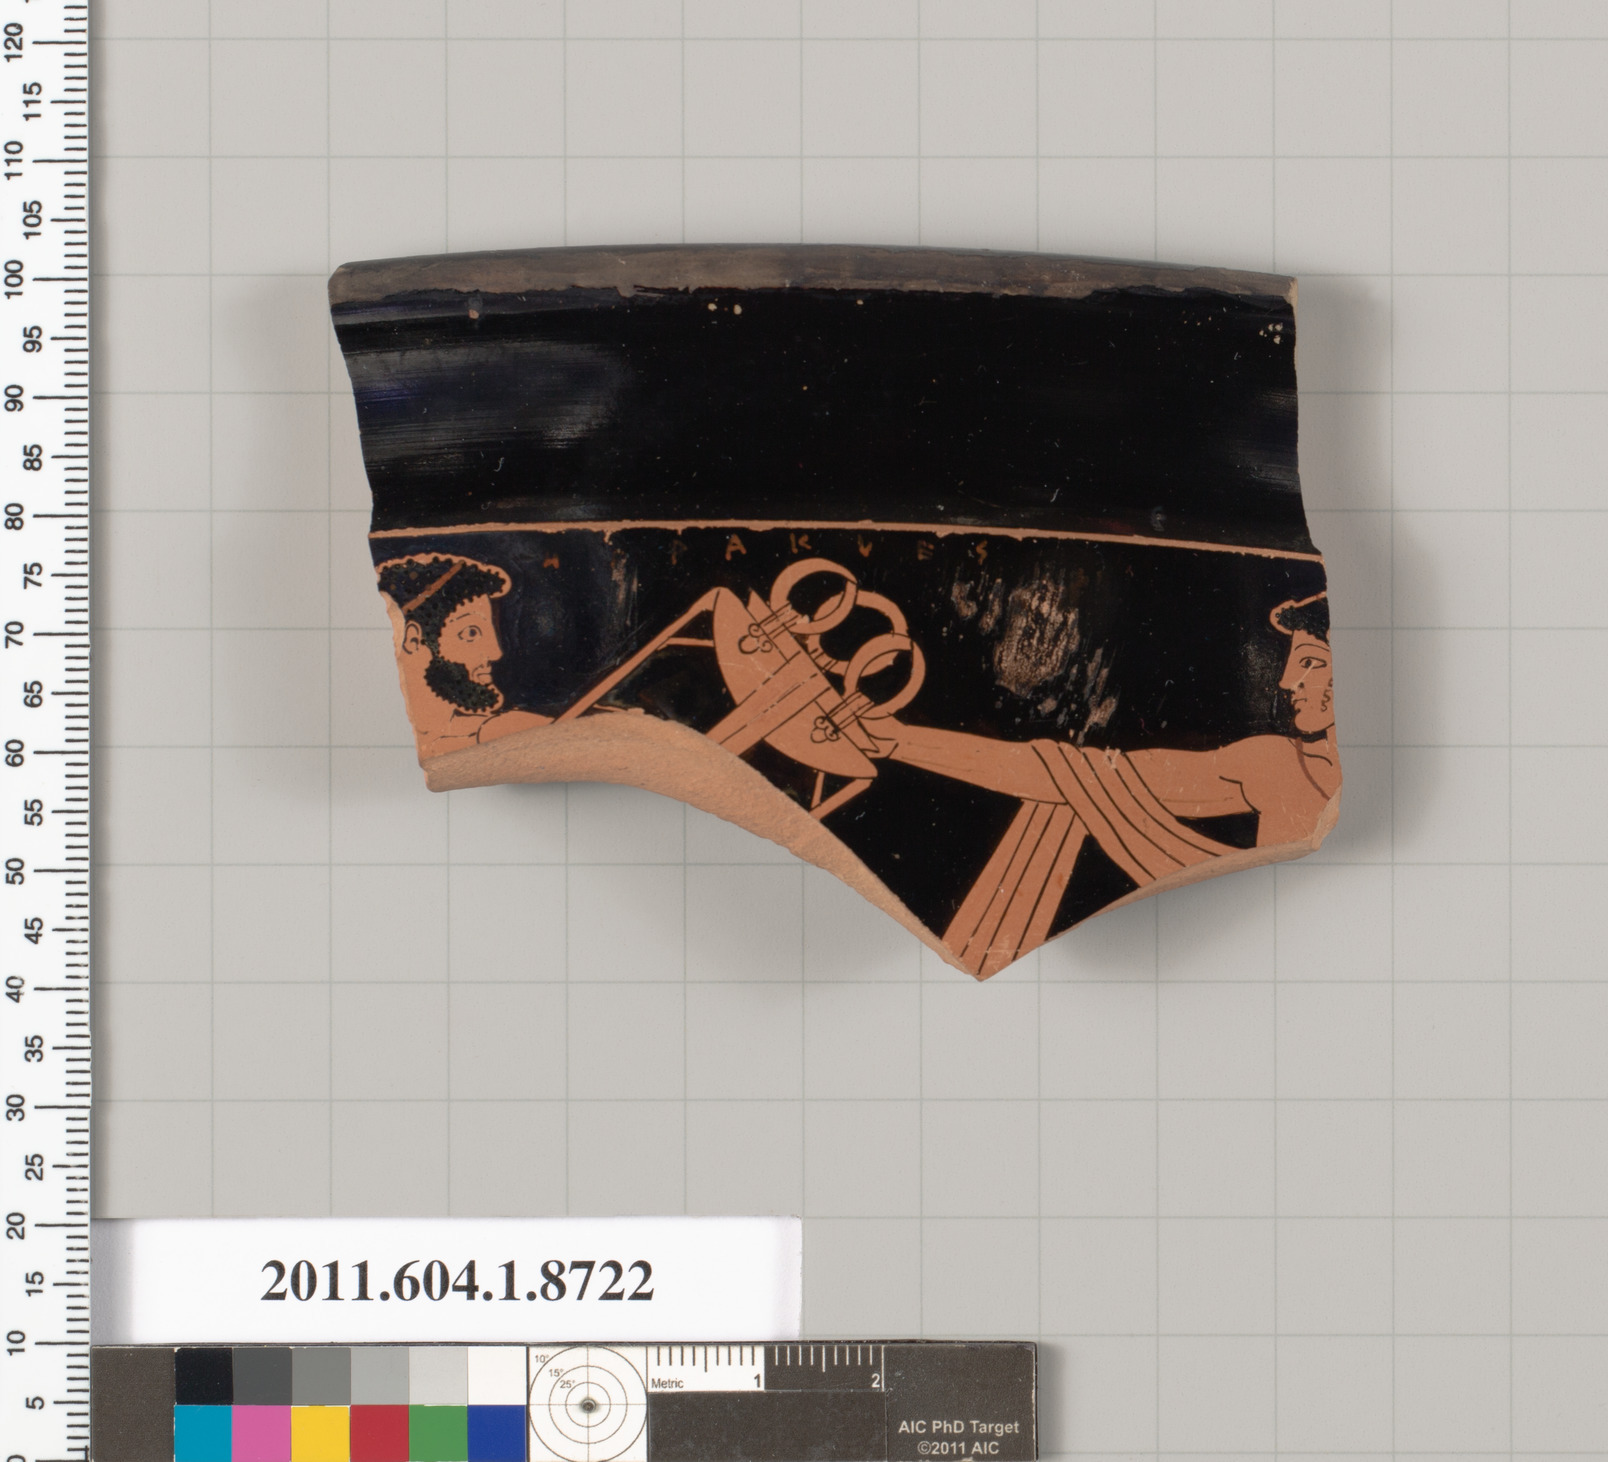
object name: kylix fragment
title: Terracotta rim fragment of a kylix (drinking cup)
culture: greek, attic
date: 500-490 BCE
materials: terracotta